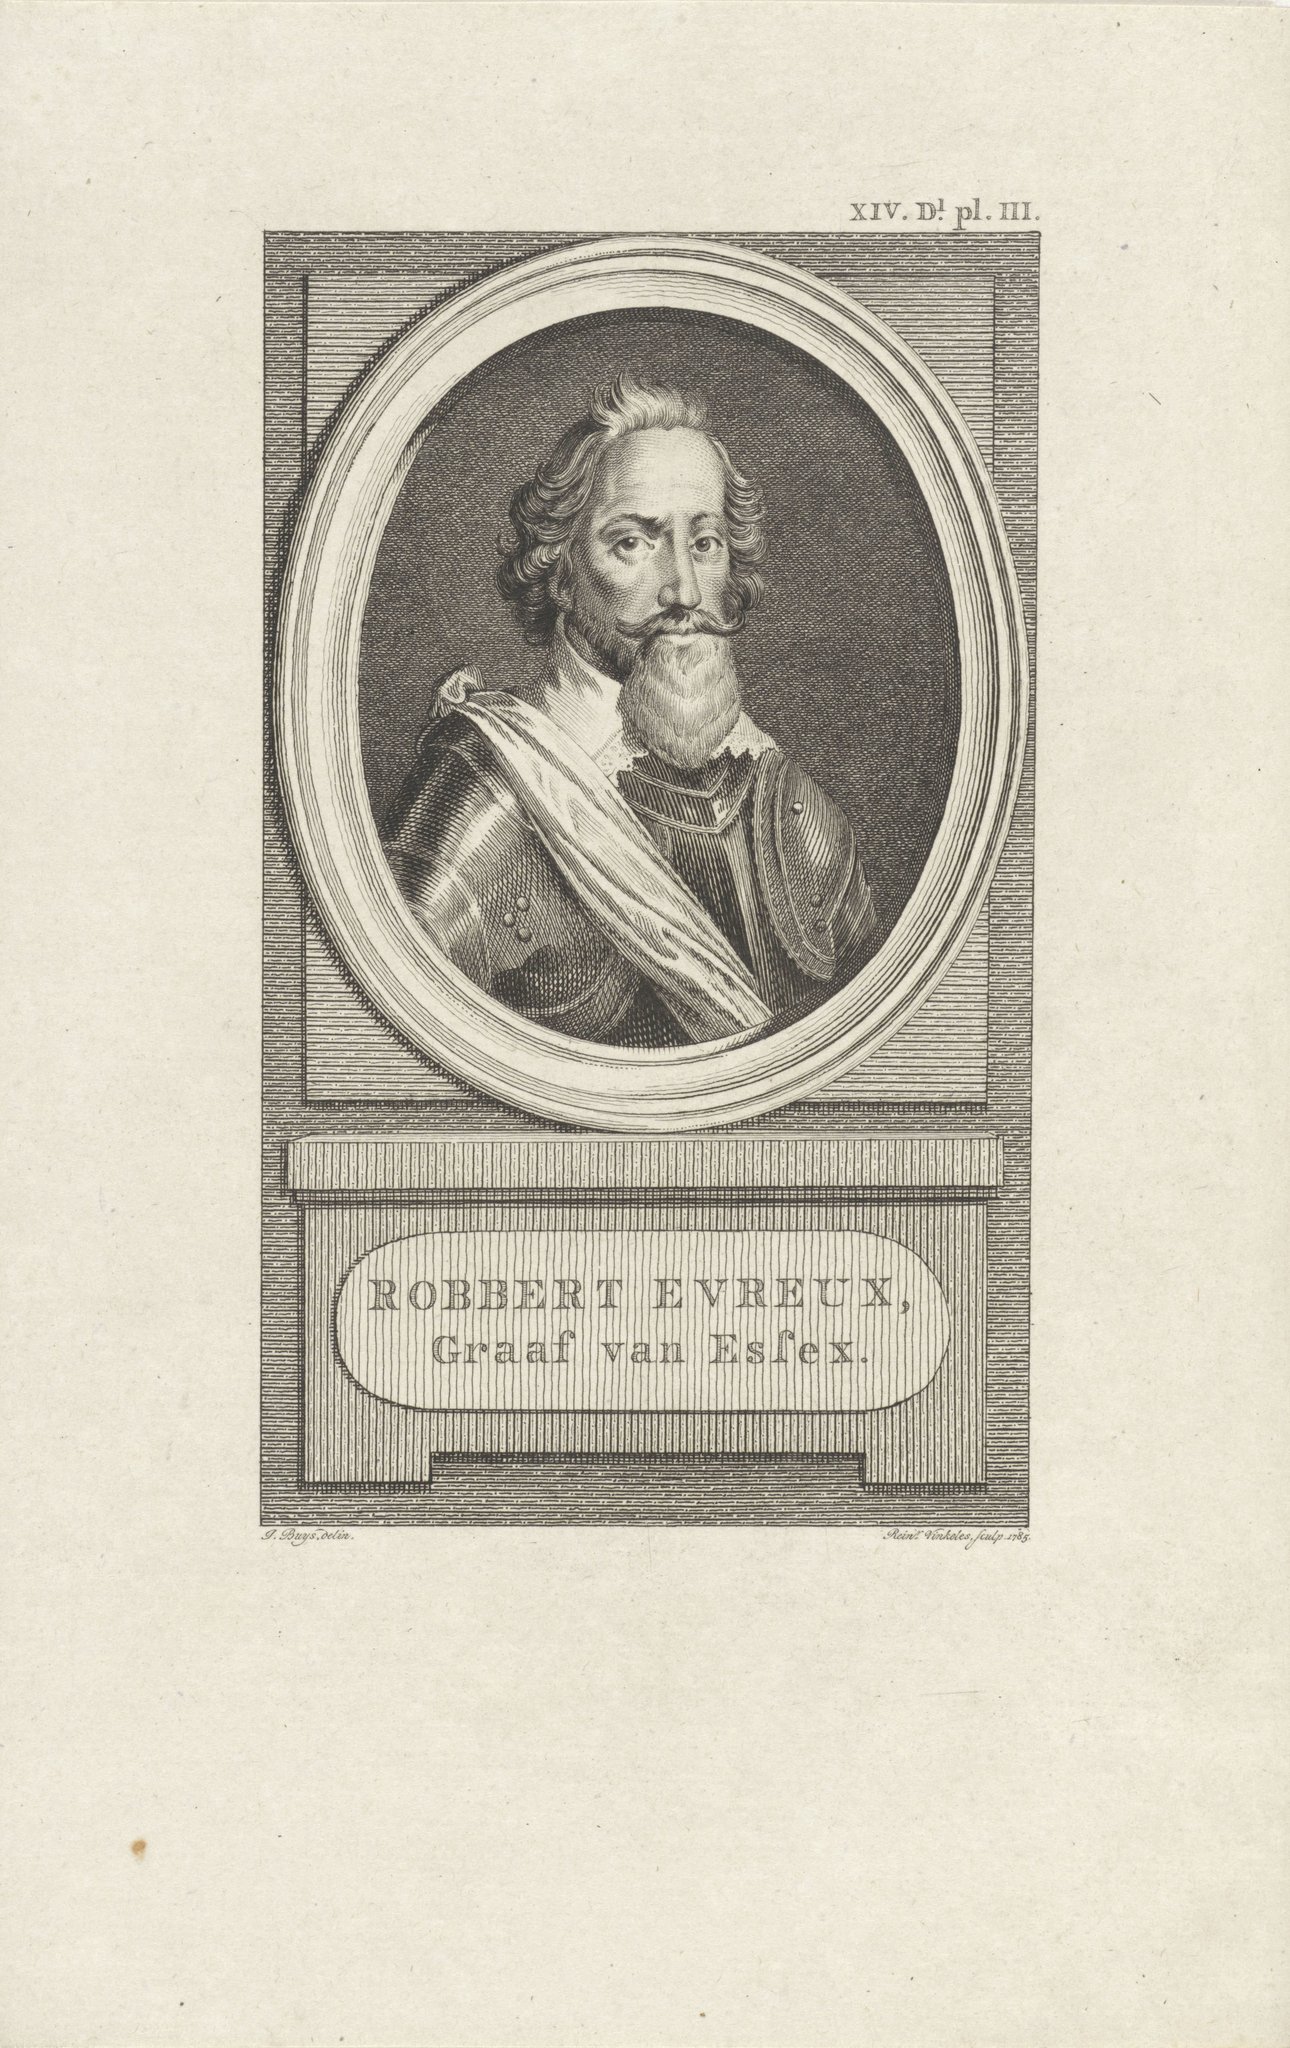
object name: print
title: Portret van Robert Devreux, graaf van Essex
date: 1785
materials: paper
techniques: engraving, etching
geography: amsterdam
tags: london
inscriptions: collector's mark: Lugt 2228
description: Prent gebruikt als boekillustratie in: Kok, Jacobus. Vaderlandsch woordenboek : met kaarten, plaaten en pourtraitten. Amsterdam: Johannes Allart, 1785-1796. Deel XIV.